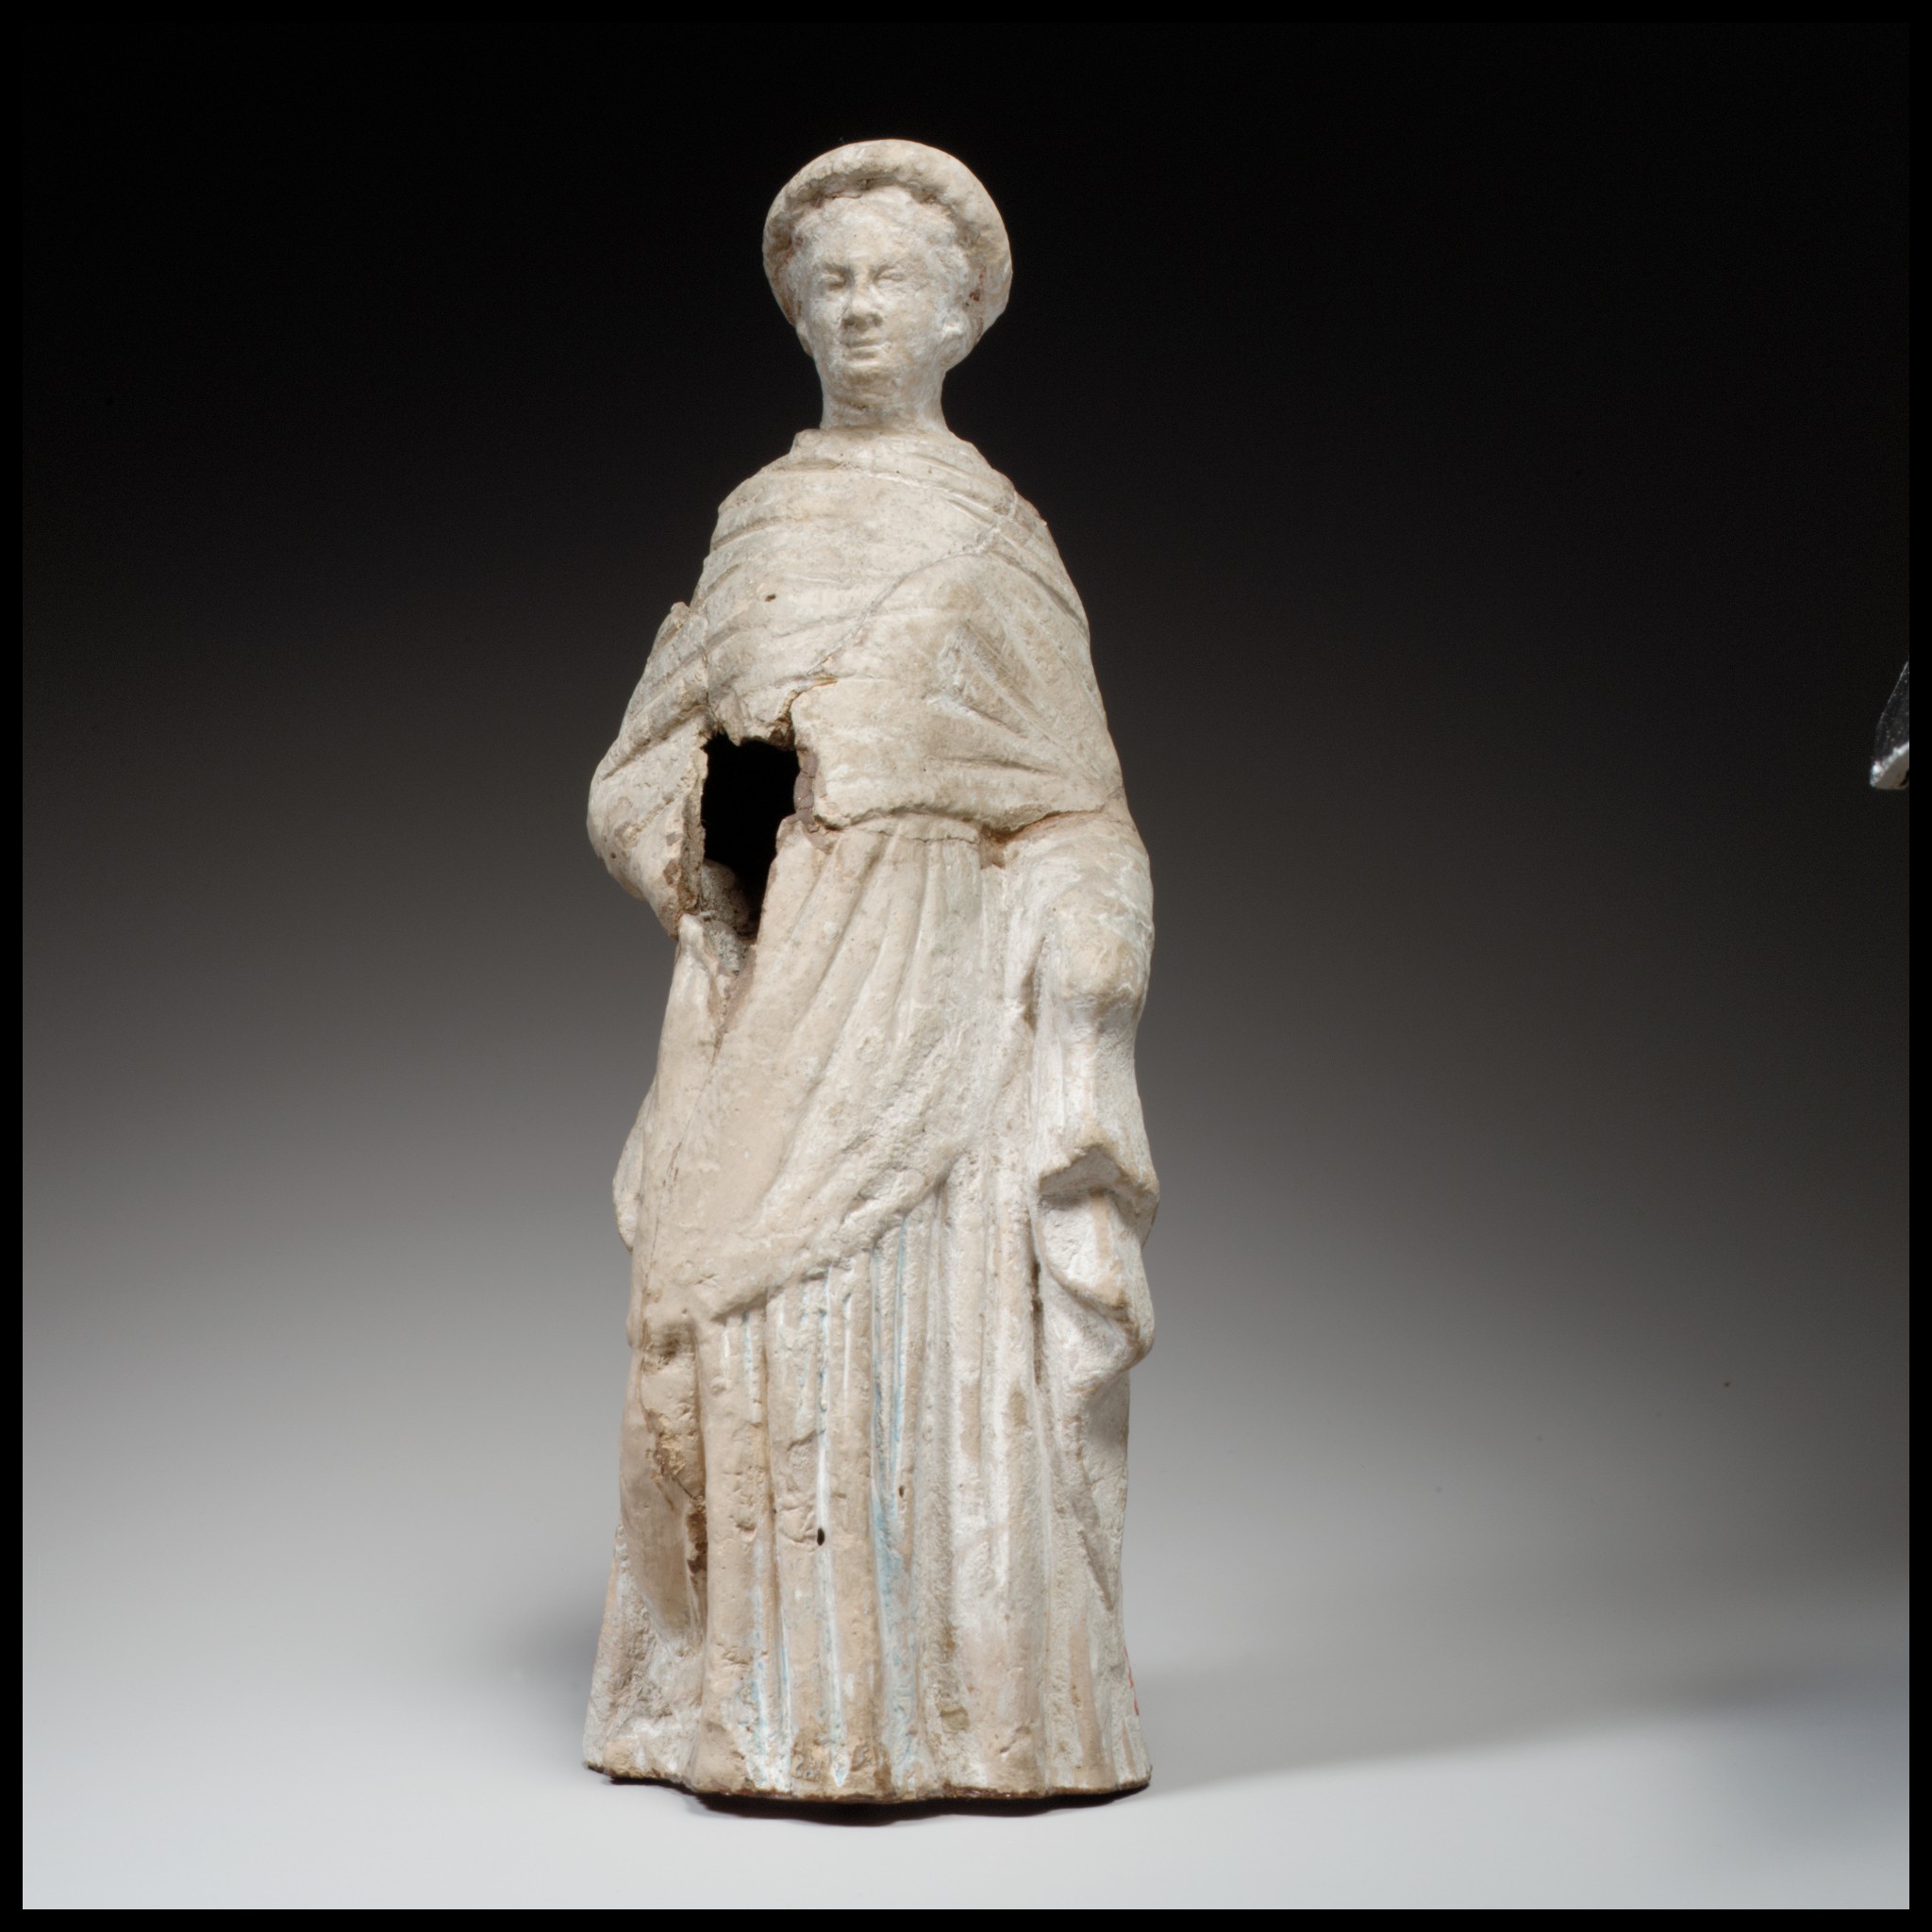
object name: statuette of a woman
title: Terracotta statuette of a woman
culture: greek, cypriot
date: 300-201 BCE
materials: terracotta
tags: women